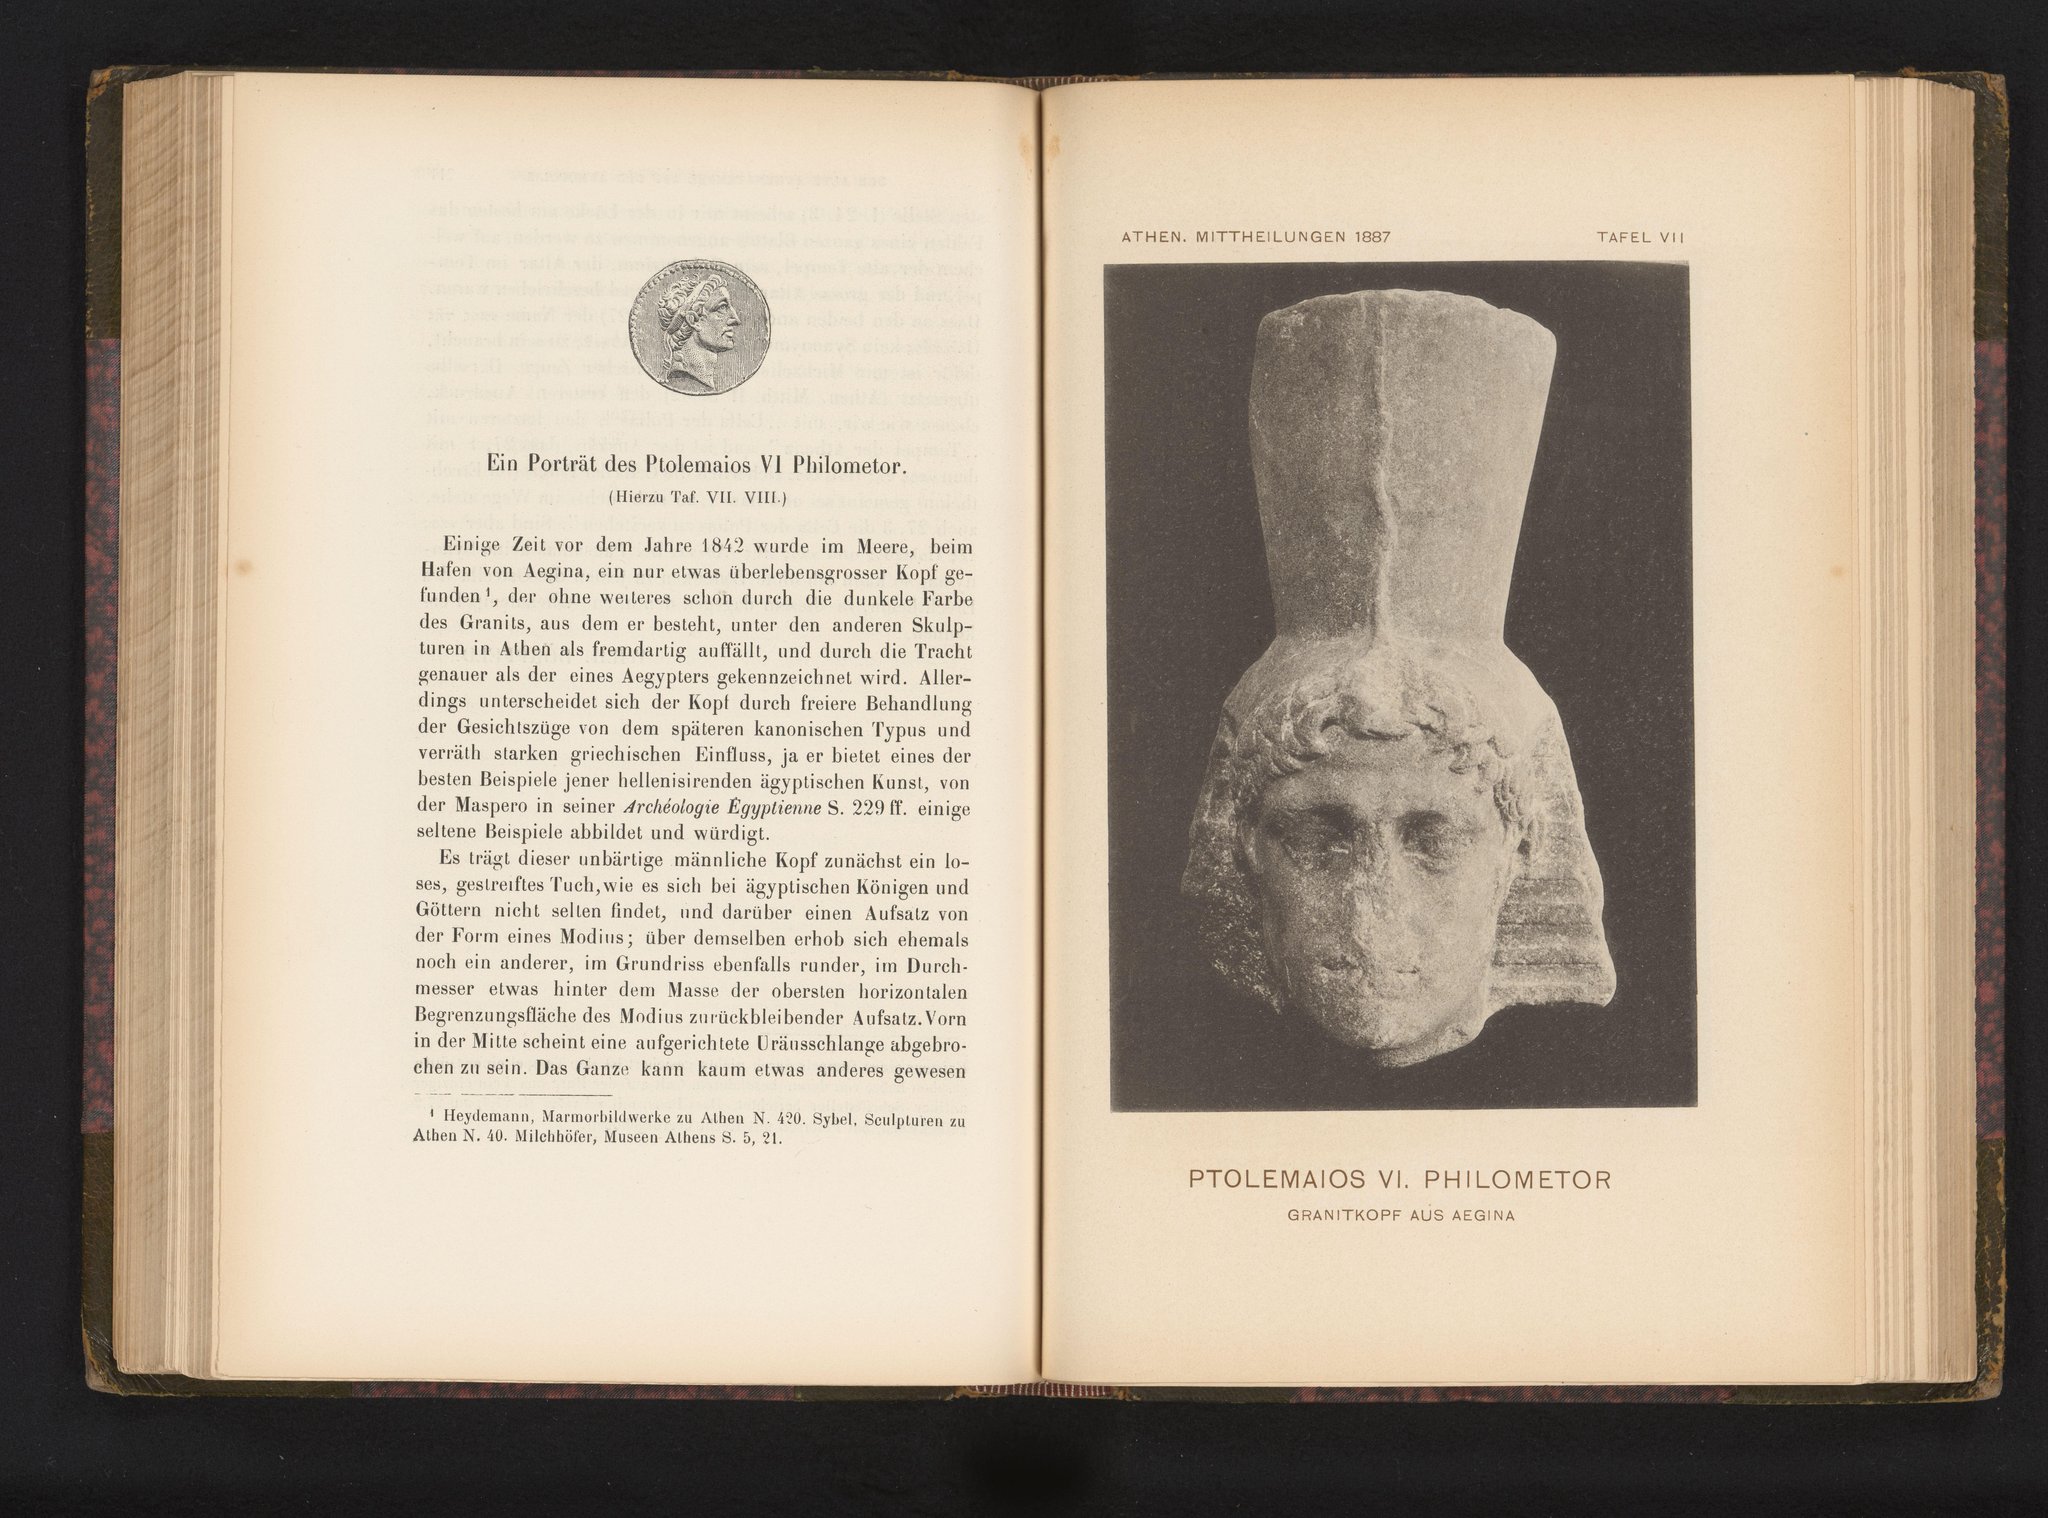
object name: page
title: Ptolemaios VI. Philometor - Ganitkopf aus Aegina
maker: Anonymous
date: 1881-1886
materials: paper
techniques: photograph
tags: head (human), sculpture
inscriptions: inscription: ‘Athen Mittheilungen 1887 Tafel VII’